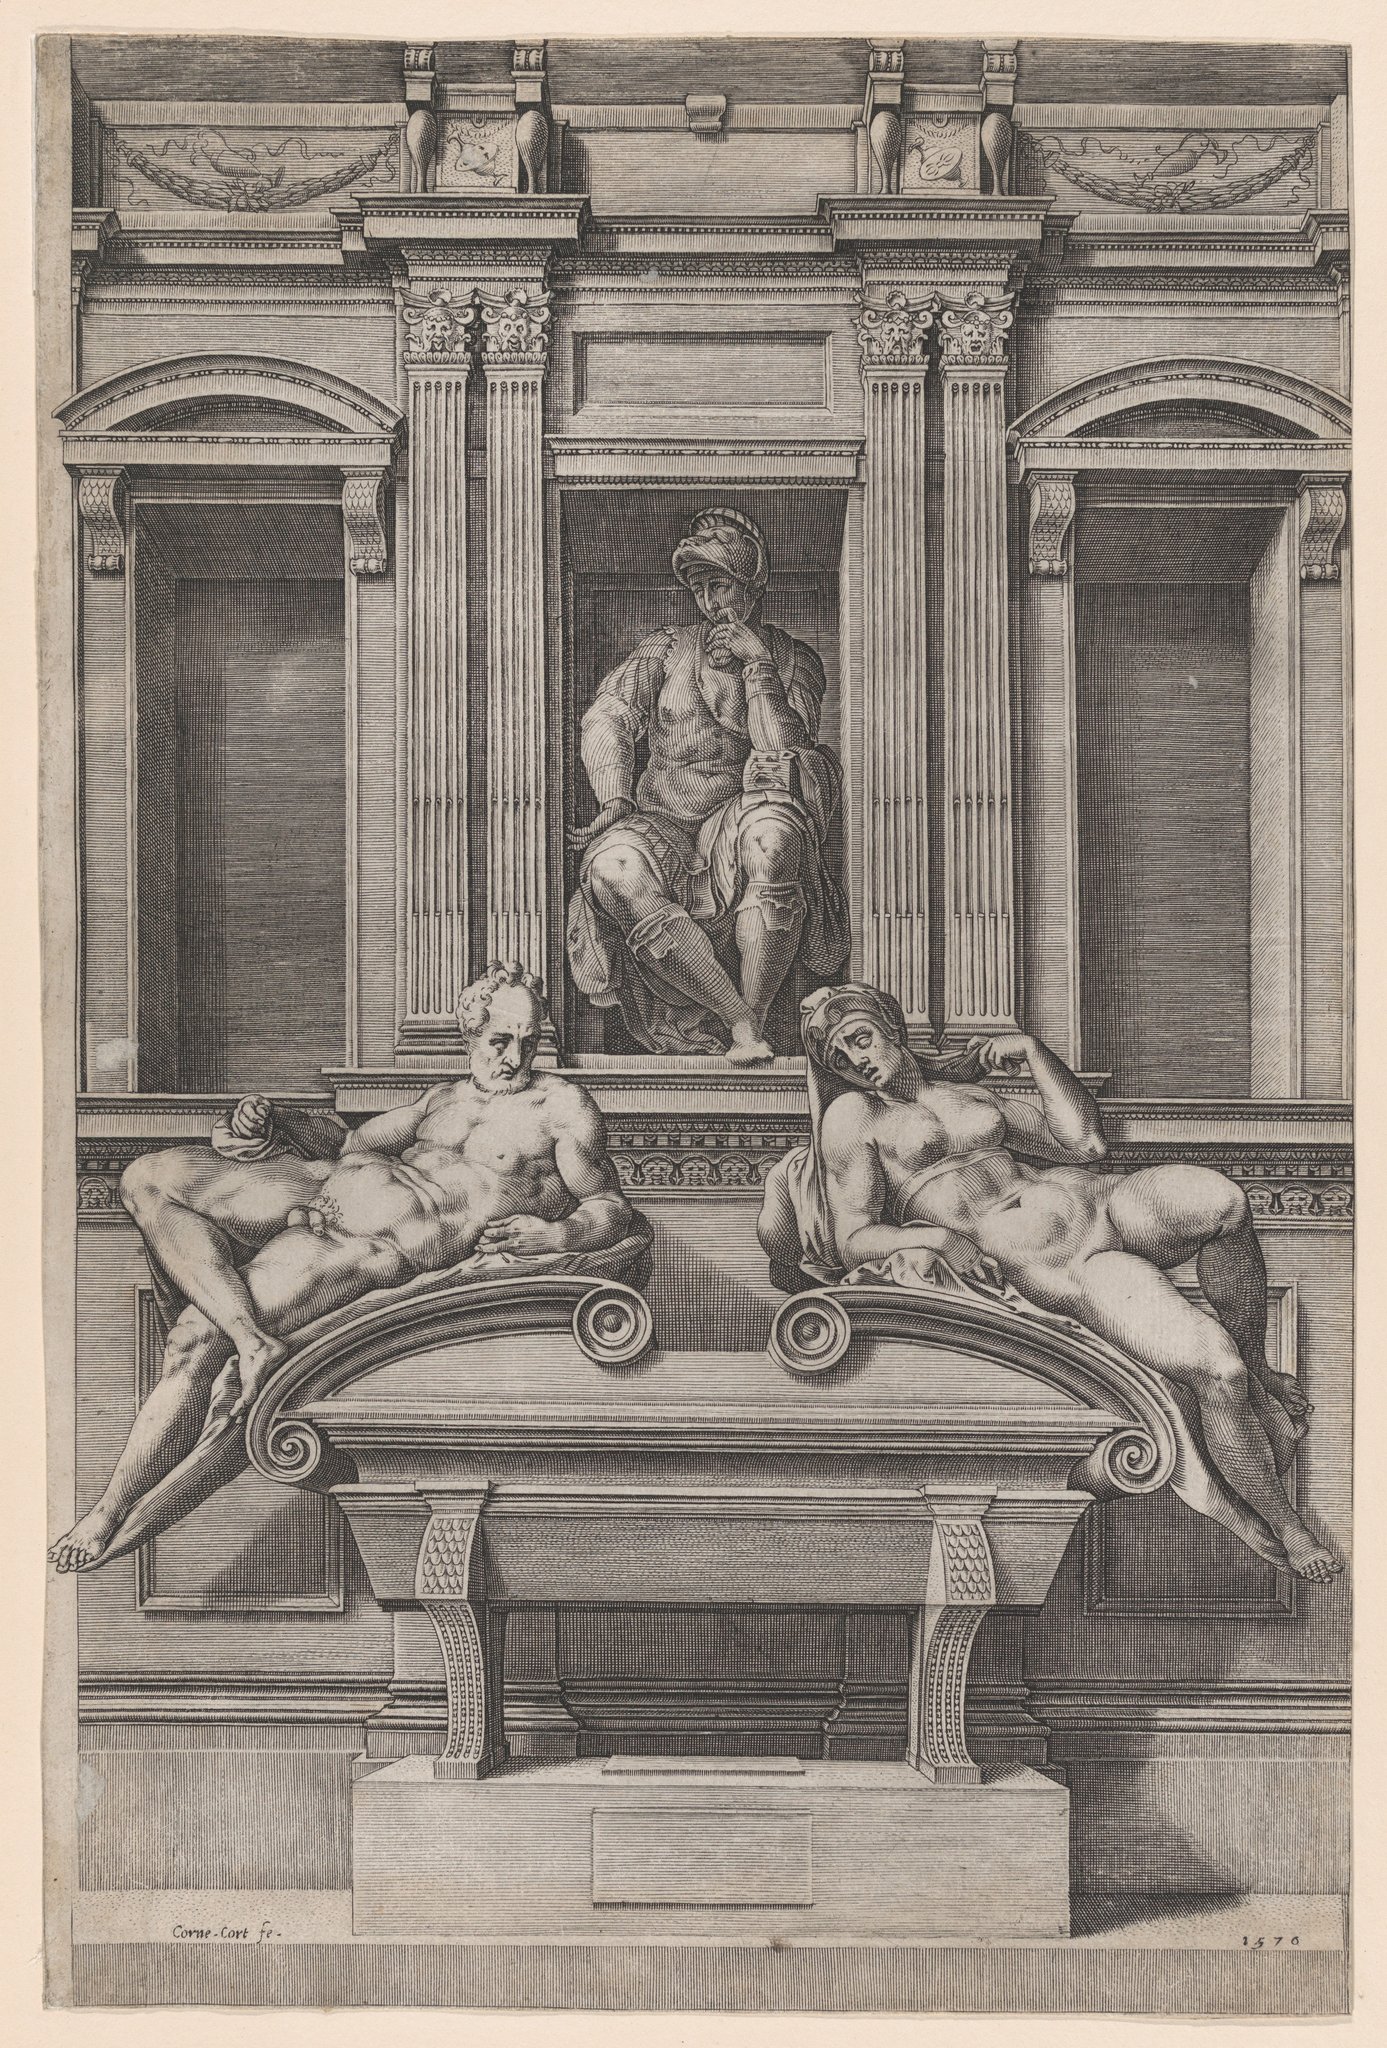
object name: print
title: The Tomb of Lorenzo de' Medici from The Tombs of the Medici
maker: cornelis cort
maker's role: artist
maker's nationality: netherlandish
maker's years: 1533-1578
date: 1570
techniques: engraving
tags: tombs,male nudes,female nudes